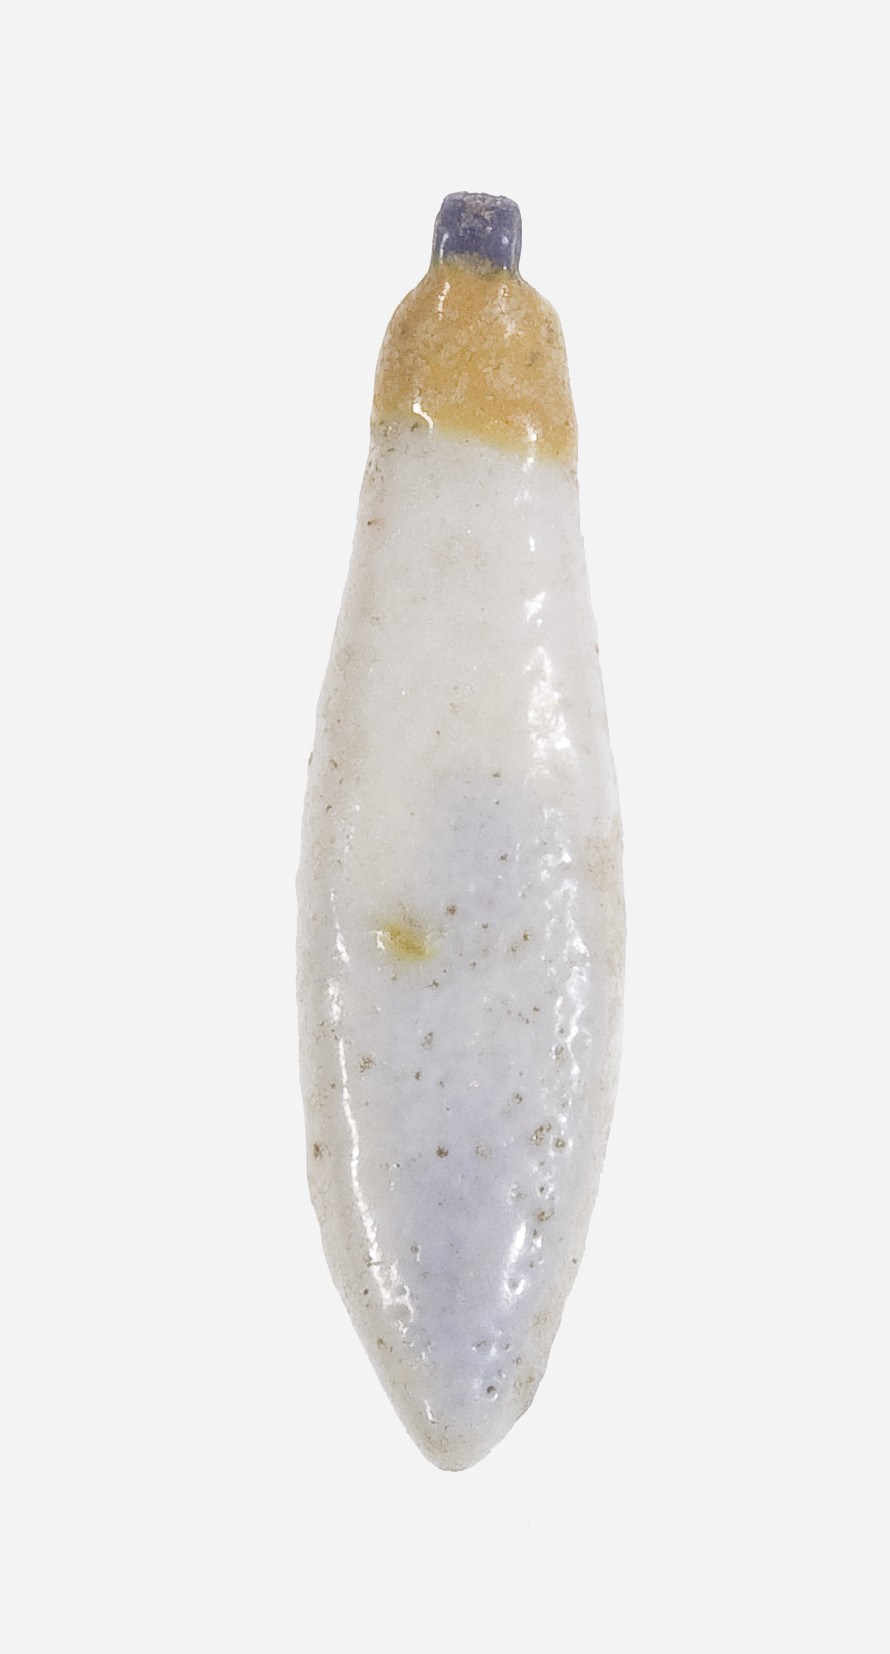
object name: bead, lotus petal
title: Bead in the Form of a Lotus Petal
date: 1390-1352 BCE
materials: faience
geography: egypt